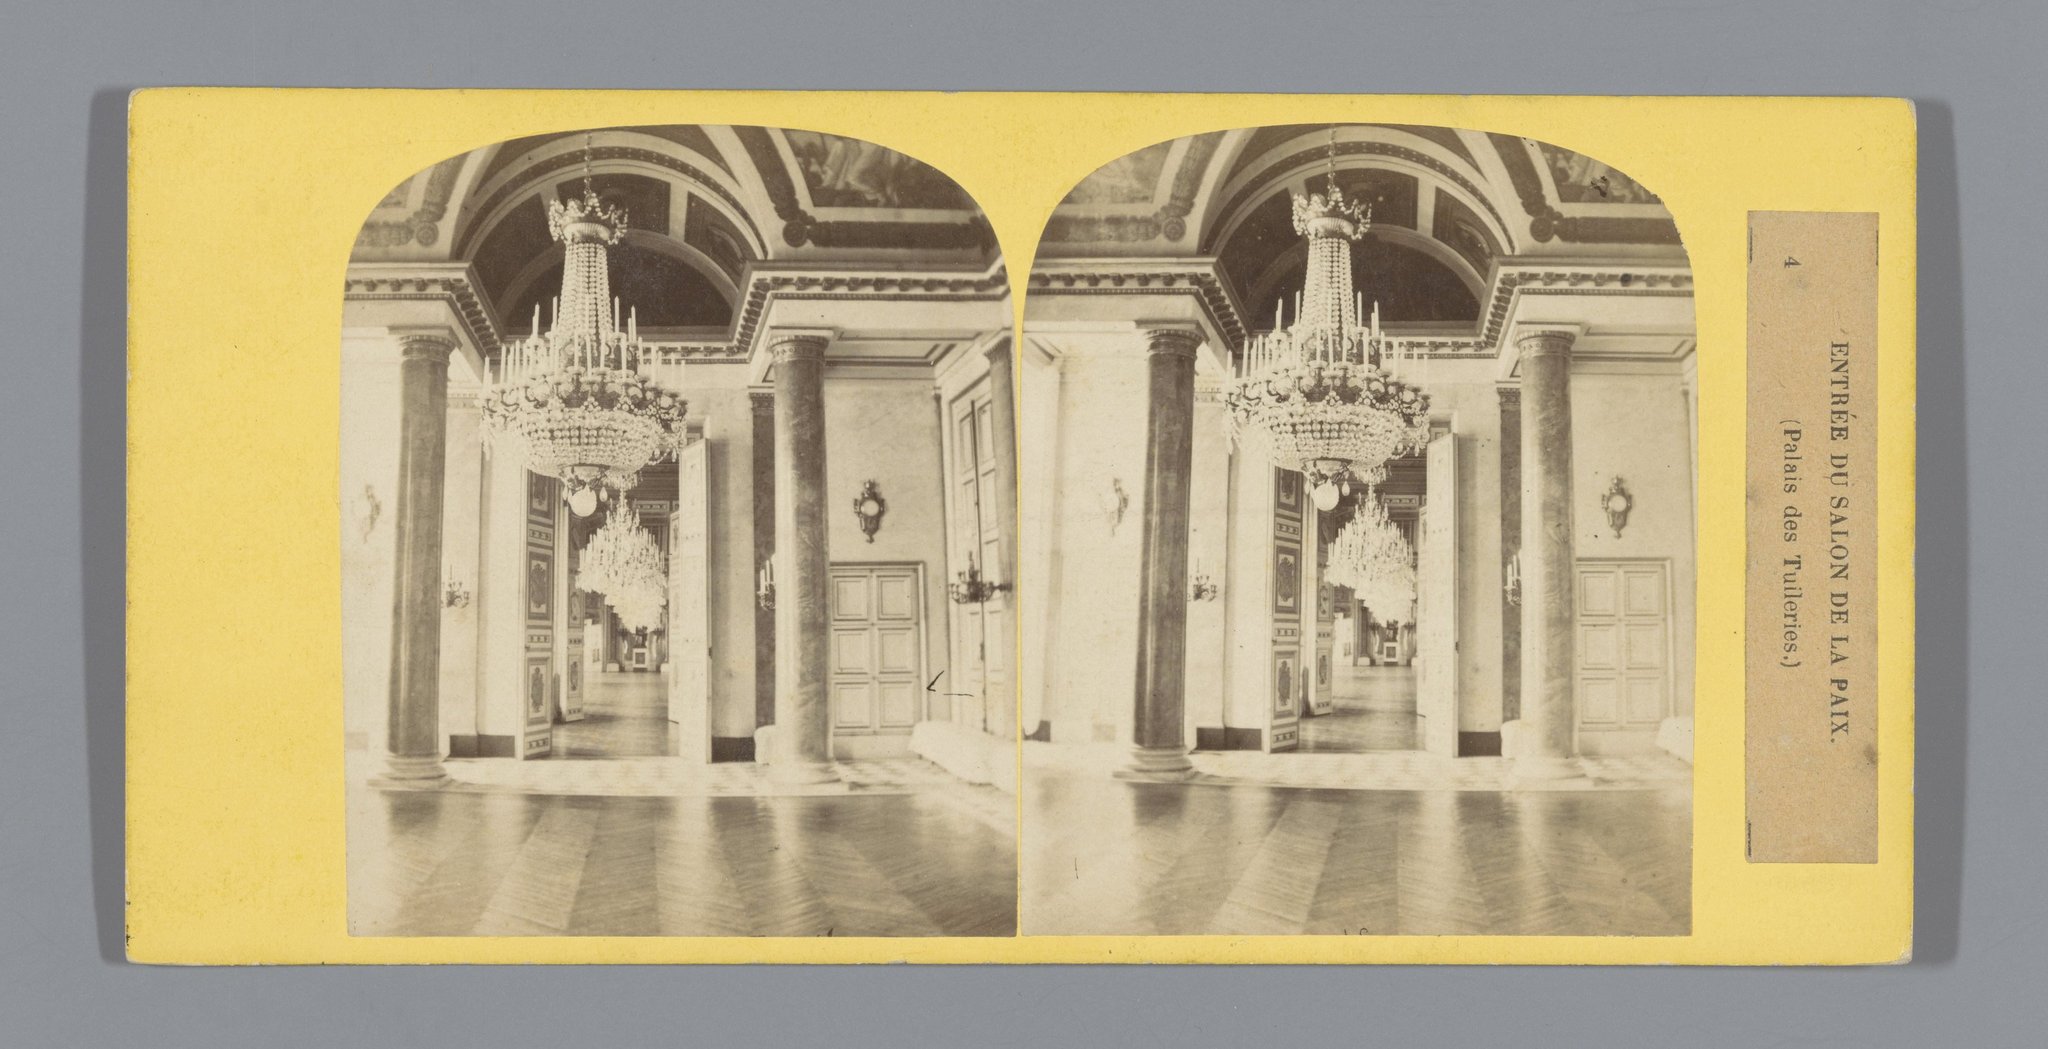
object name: stereograph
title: Toegang naar de Salon de la Paix in het Palais des Tuileries te Parijs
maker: Anonymous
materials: cardboard, photographic support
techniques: albumen print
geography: tuileries palace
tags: drawing-room, 'salon', interior ~ representation of a building, tuileries palace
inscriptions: number: ‘4’